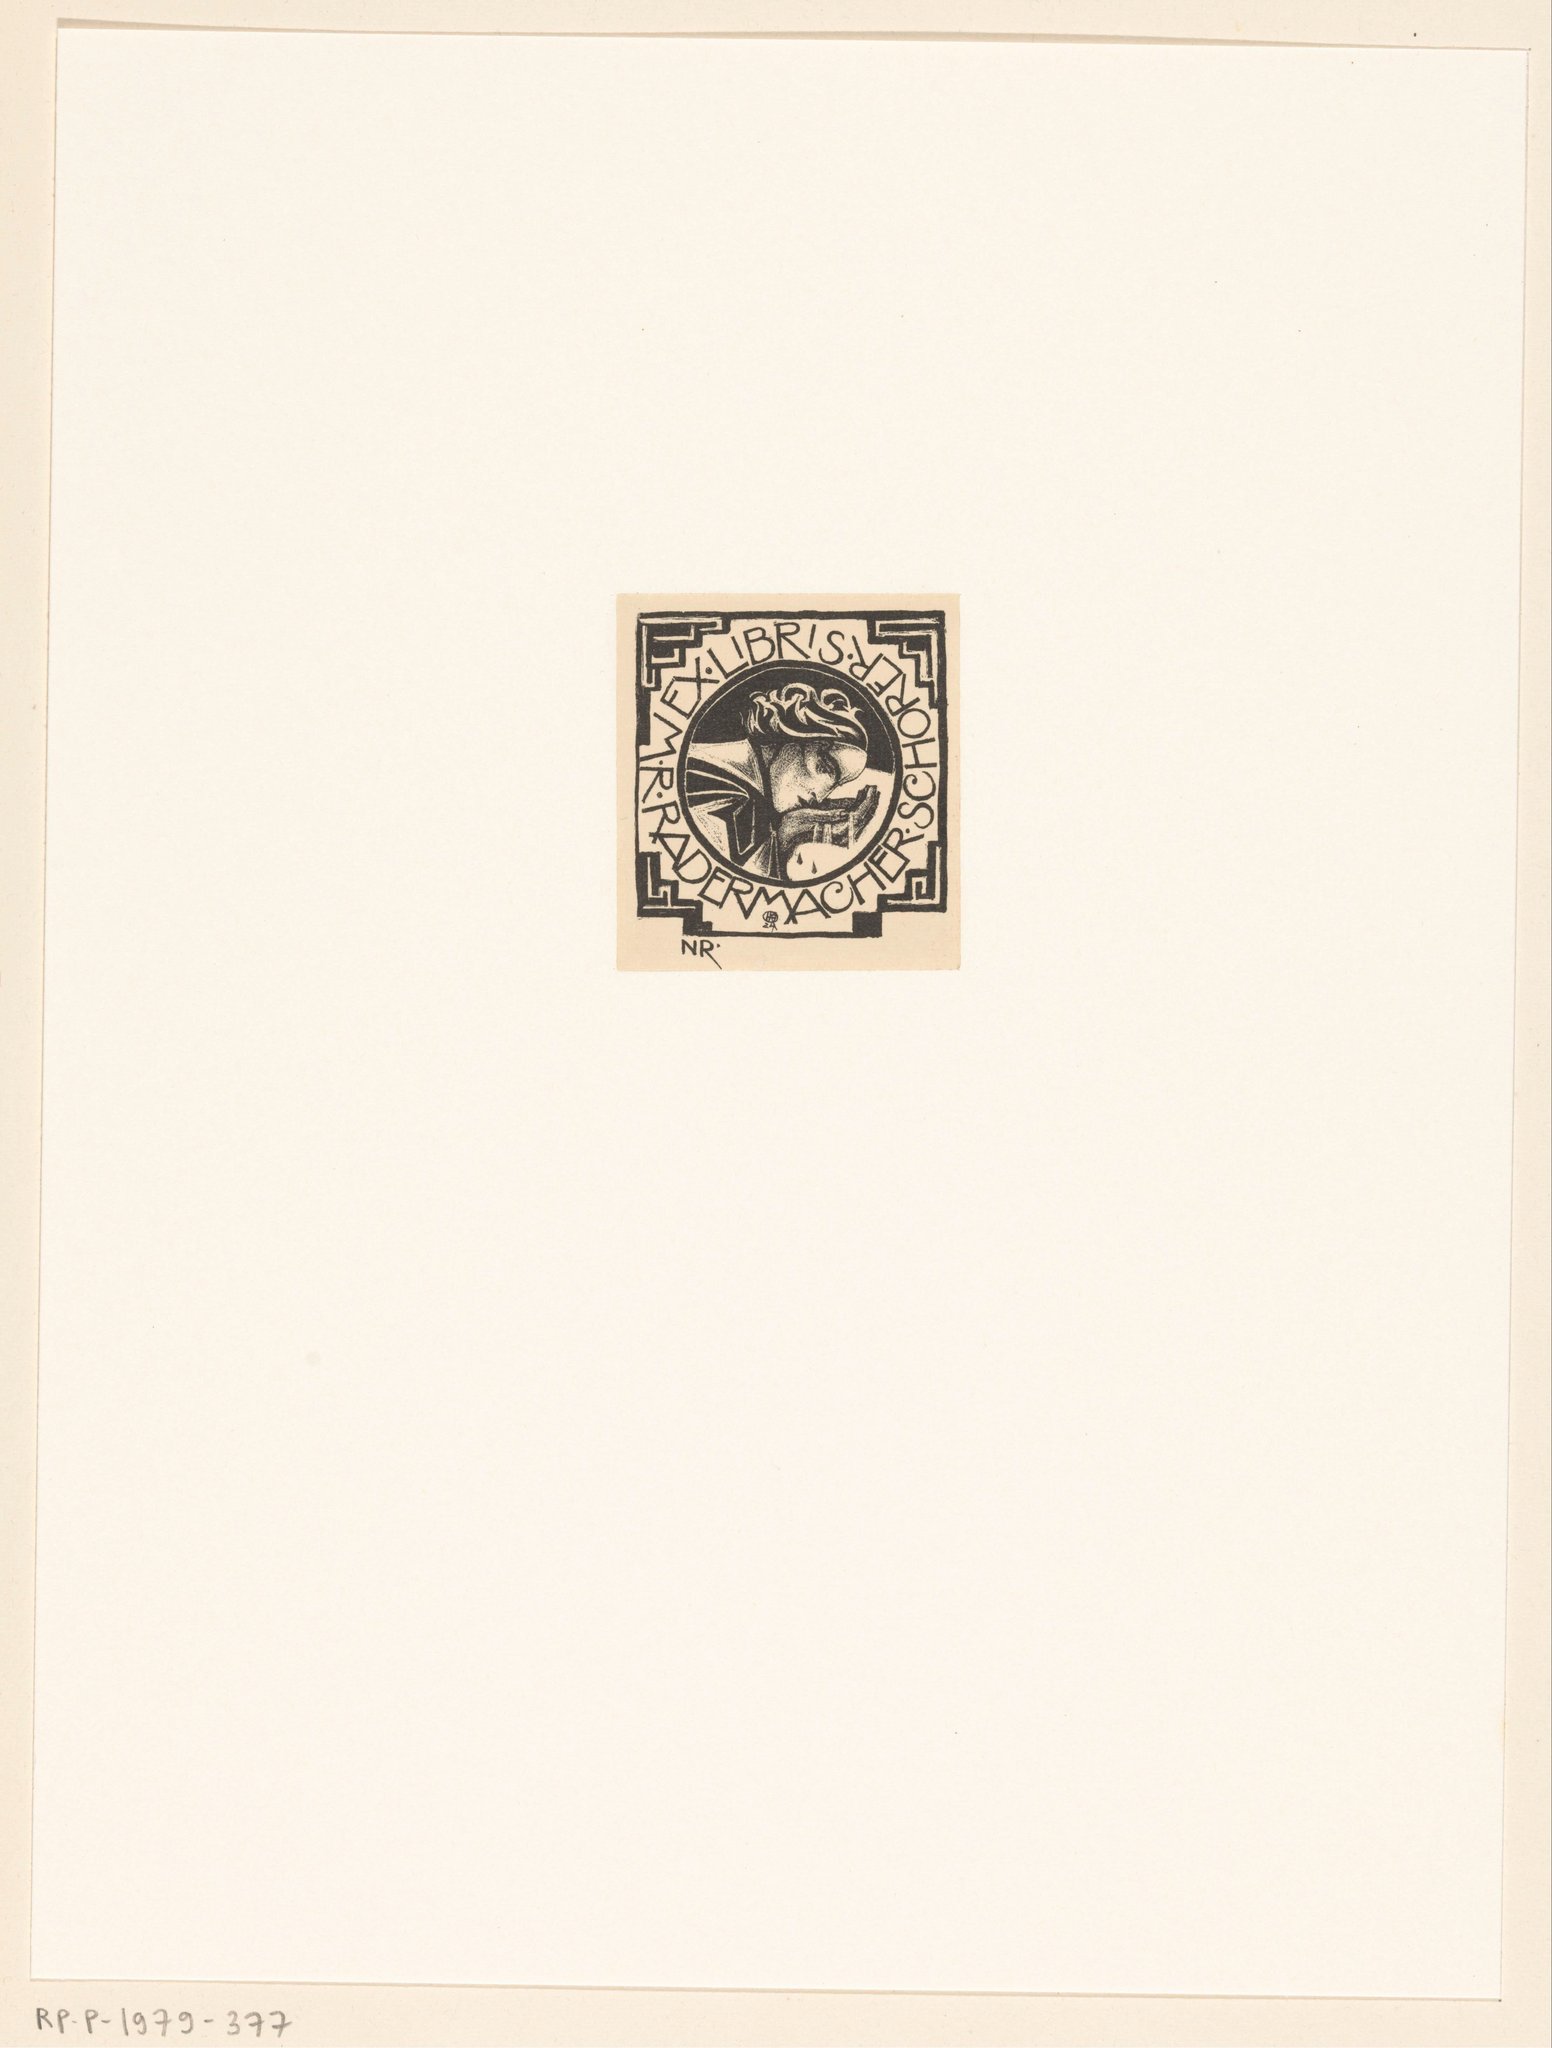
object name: print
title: Ex libris van M.R. Radermacher Schorer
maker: richard nicolaüs roland holst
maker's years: 1868-1938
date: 1924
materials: paper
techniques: lithograph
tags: utrecht, head (human), drinking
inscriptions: collector's mark: Lugt 2228